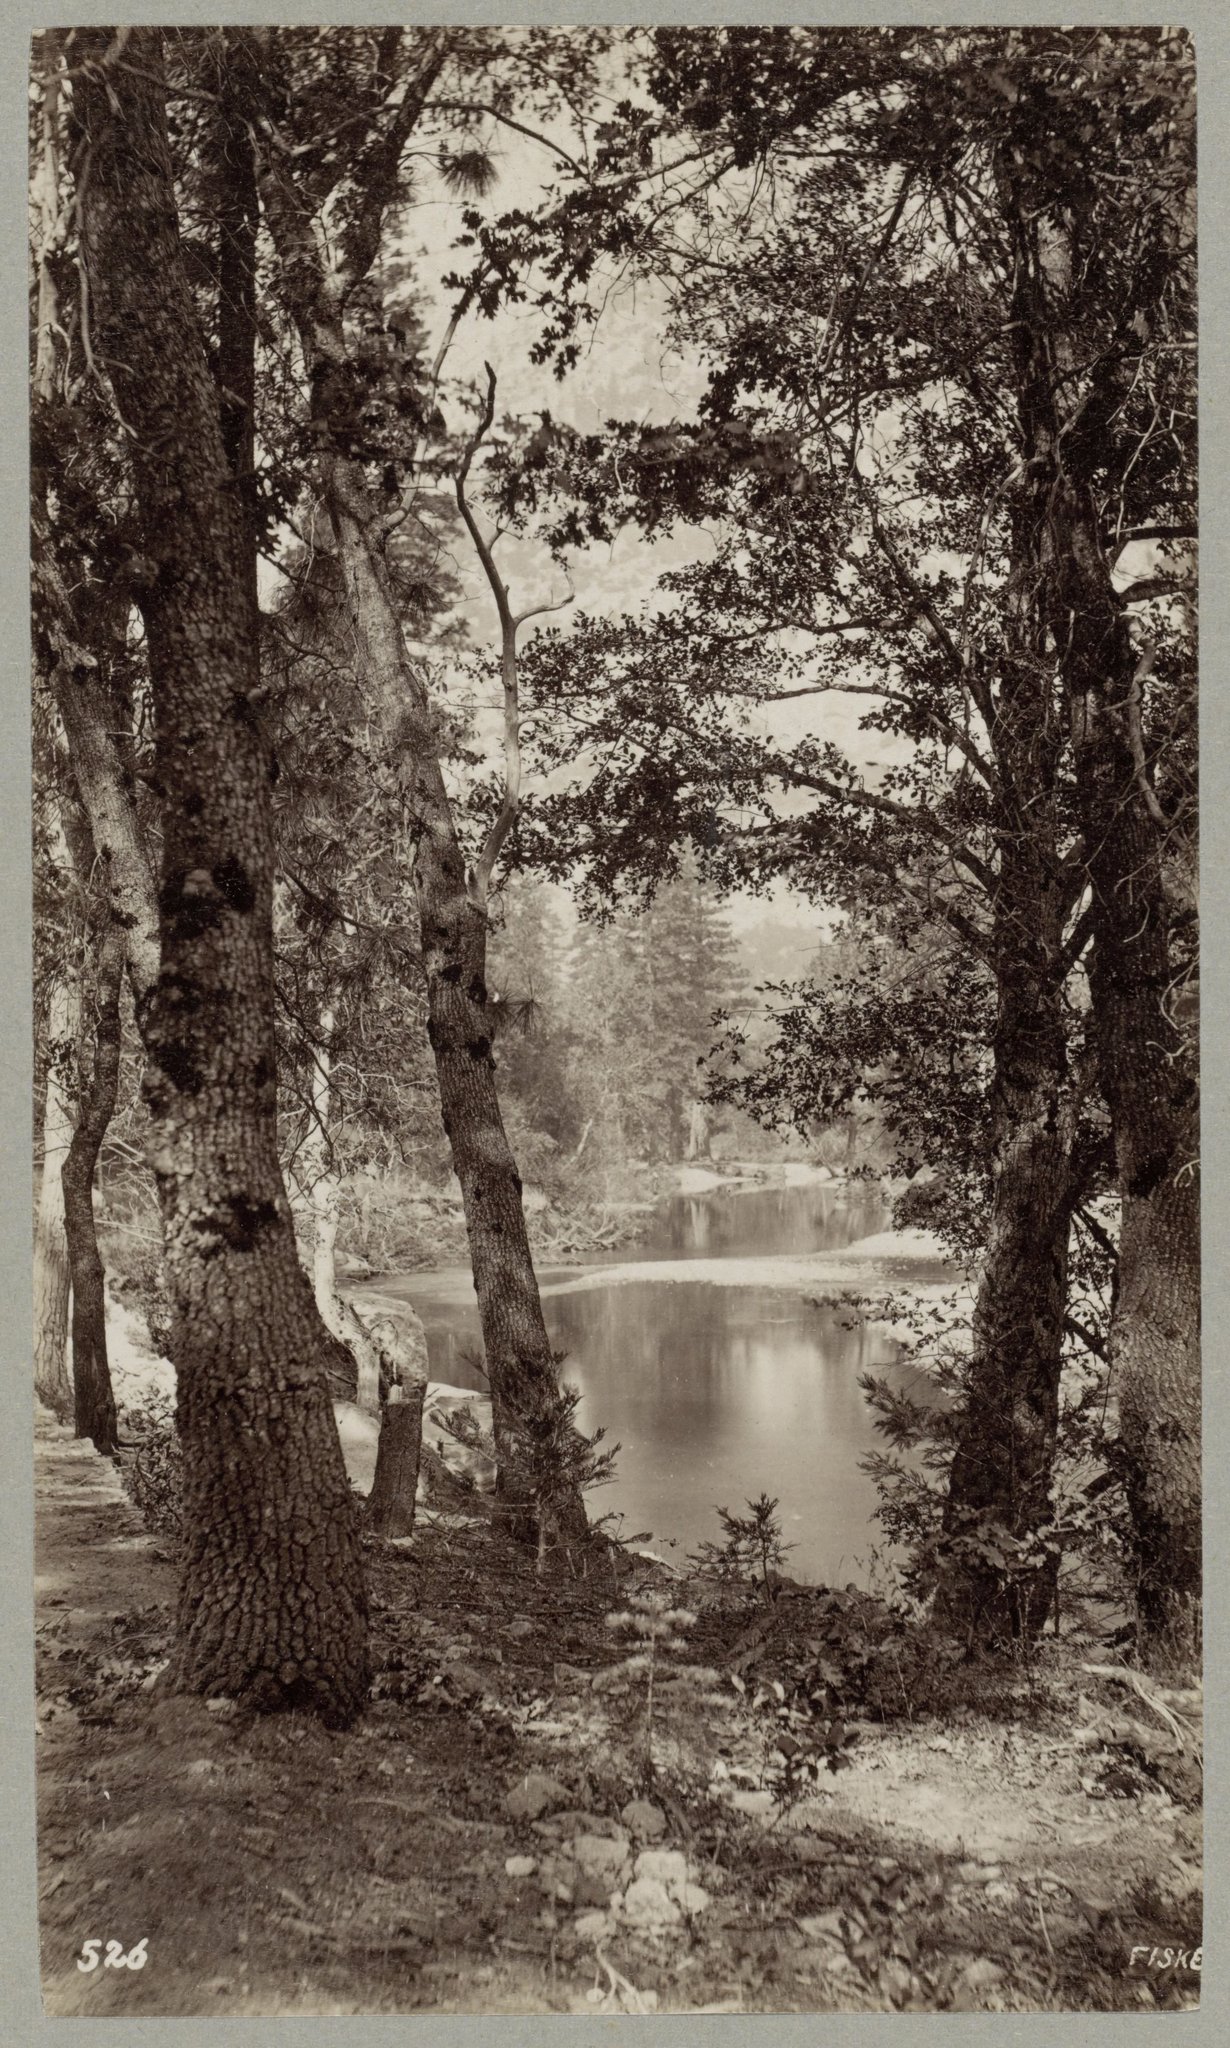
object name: photograph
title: Bomen aan de oever van een water in de Verenigde Staten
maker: george fiske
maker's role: fotograaf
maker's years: 1835-1918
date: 1880-1900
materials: cardboard, paper, photographic support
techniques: albumen print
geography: united states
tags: river bank, united states of america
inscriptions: negative number: ‘526’